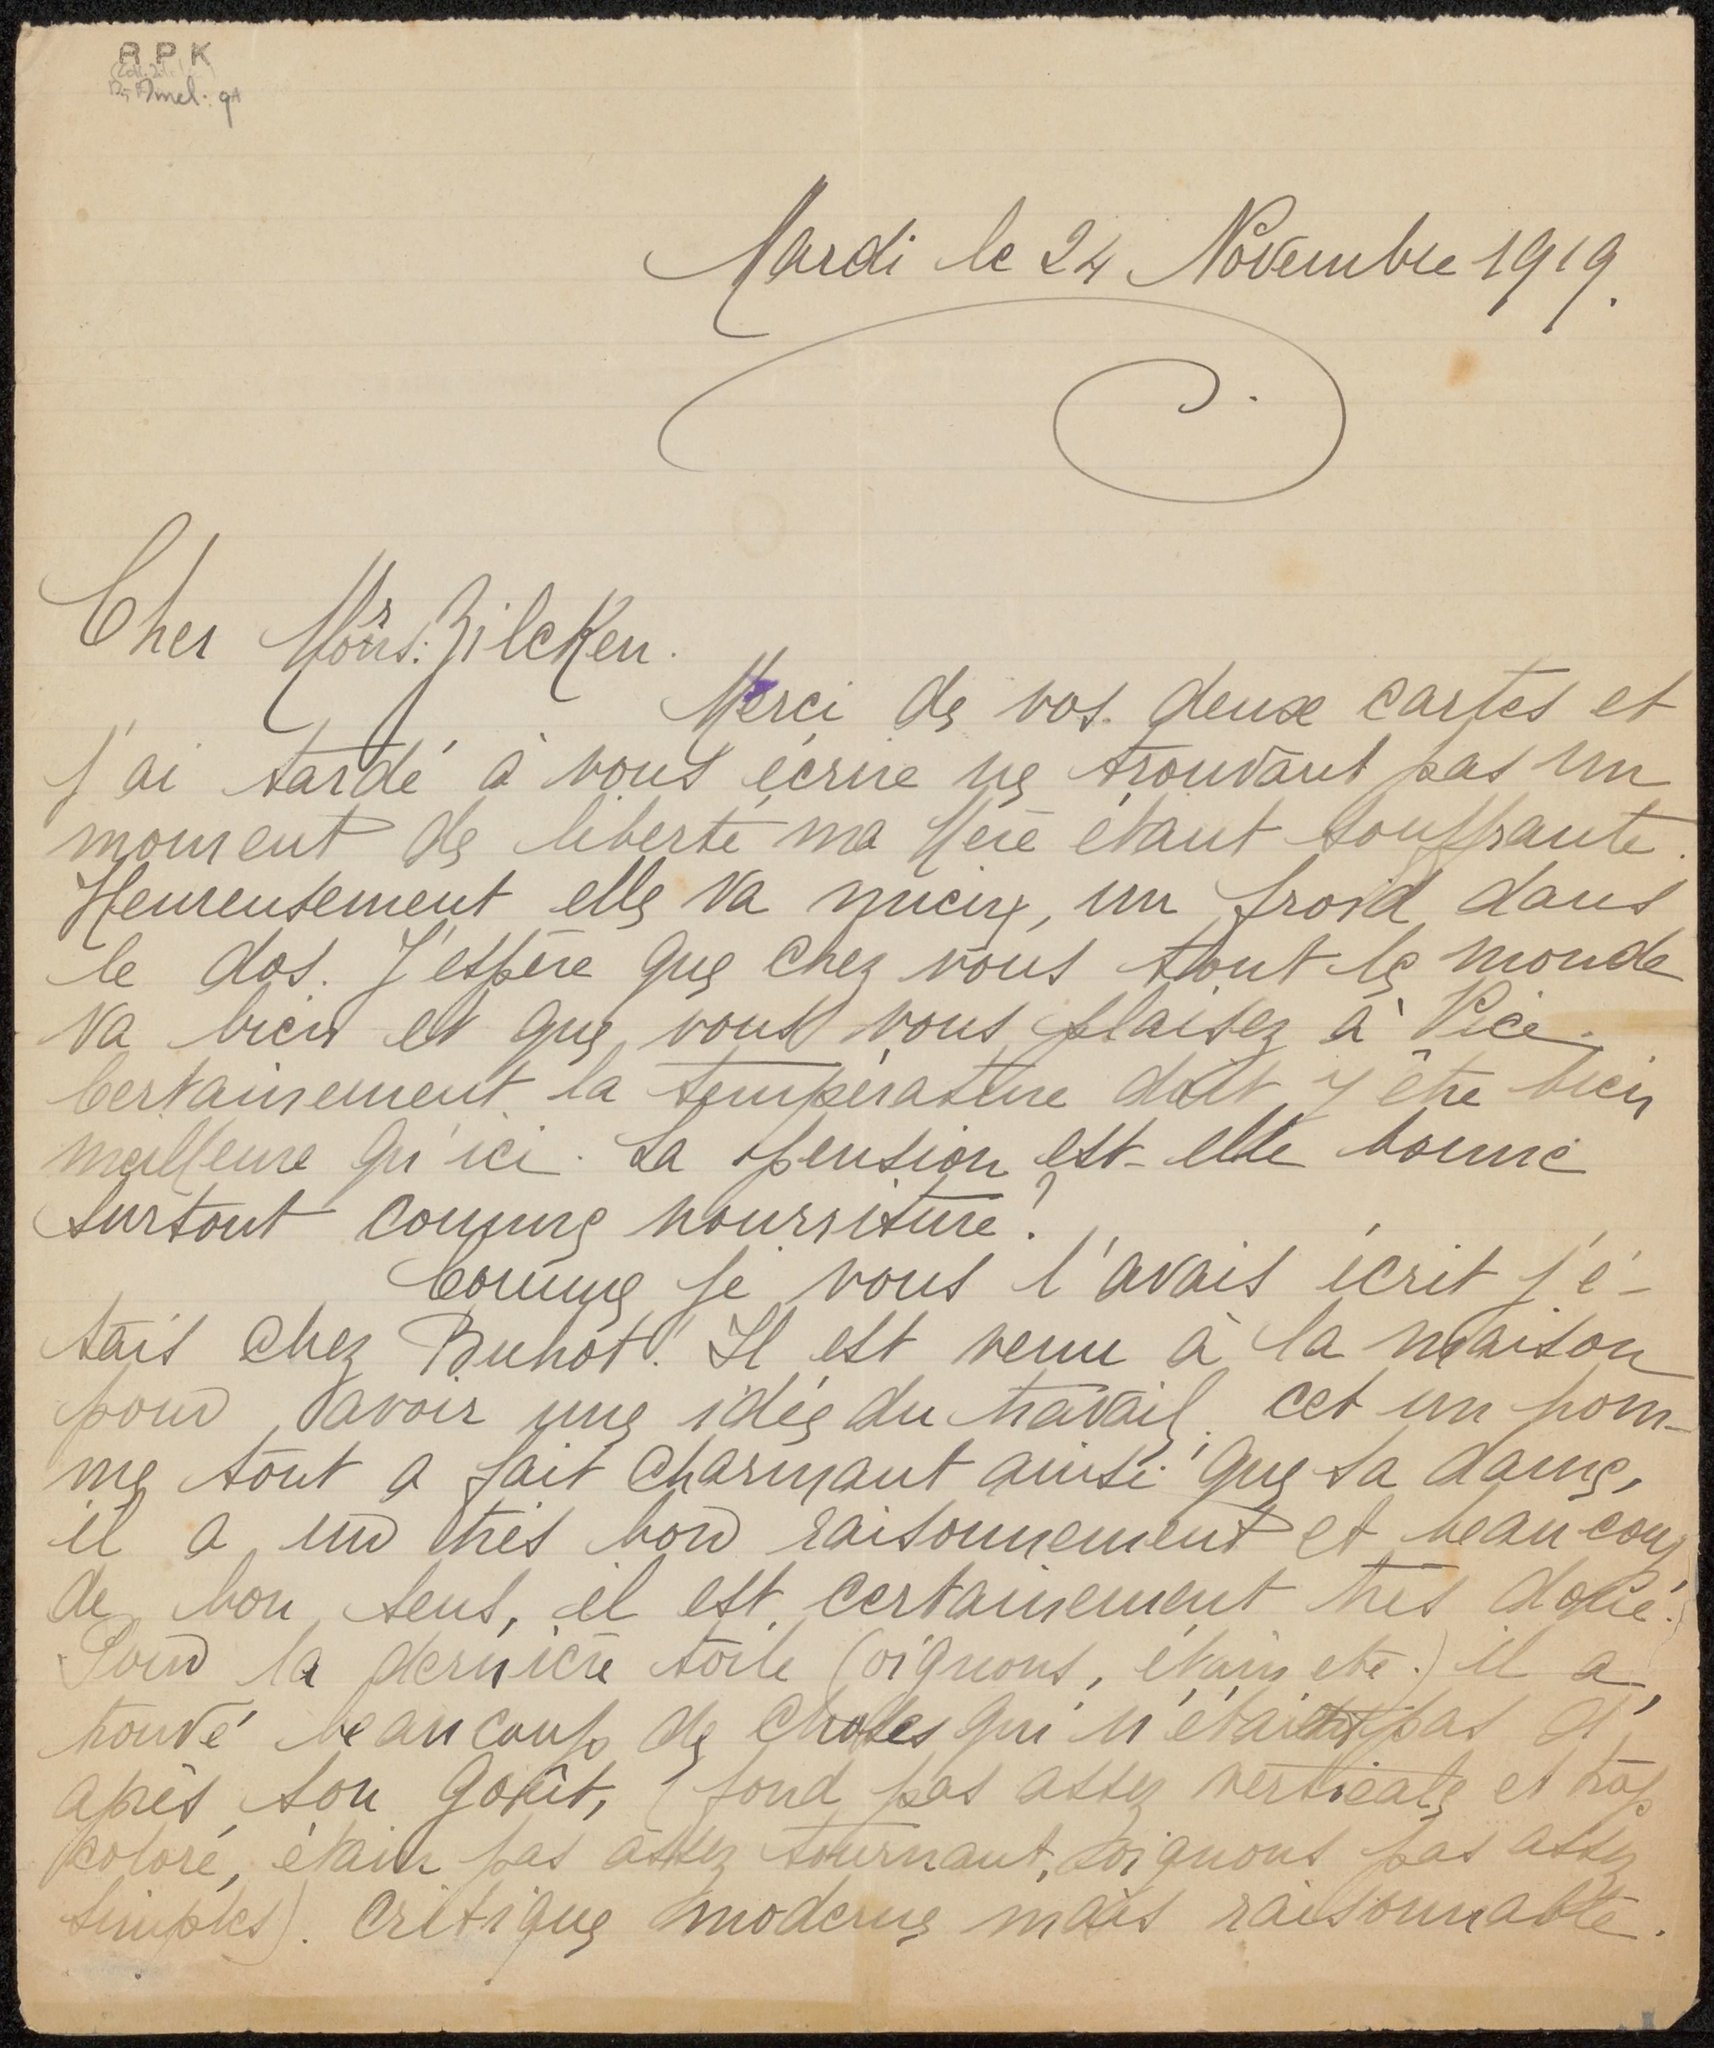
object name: letter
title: Brief aan Philip Zilcken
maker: rose imel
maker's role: draughtsman, painter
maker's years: 1901-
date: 1919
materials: ink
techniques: pen, writing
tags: théophile alexandre steinlen, paris, jean buhot, the hague, painter, philip zilcken, painting (including book-illumination, miniature-painting), temporary exhibition, 'salon'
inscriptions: collector's mark: ‘RPK’